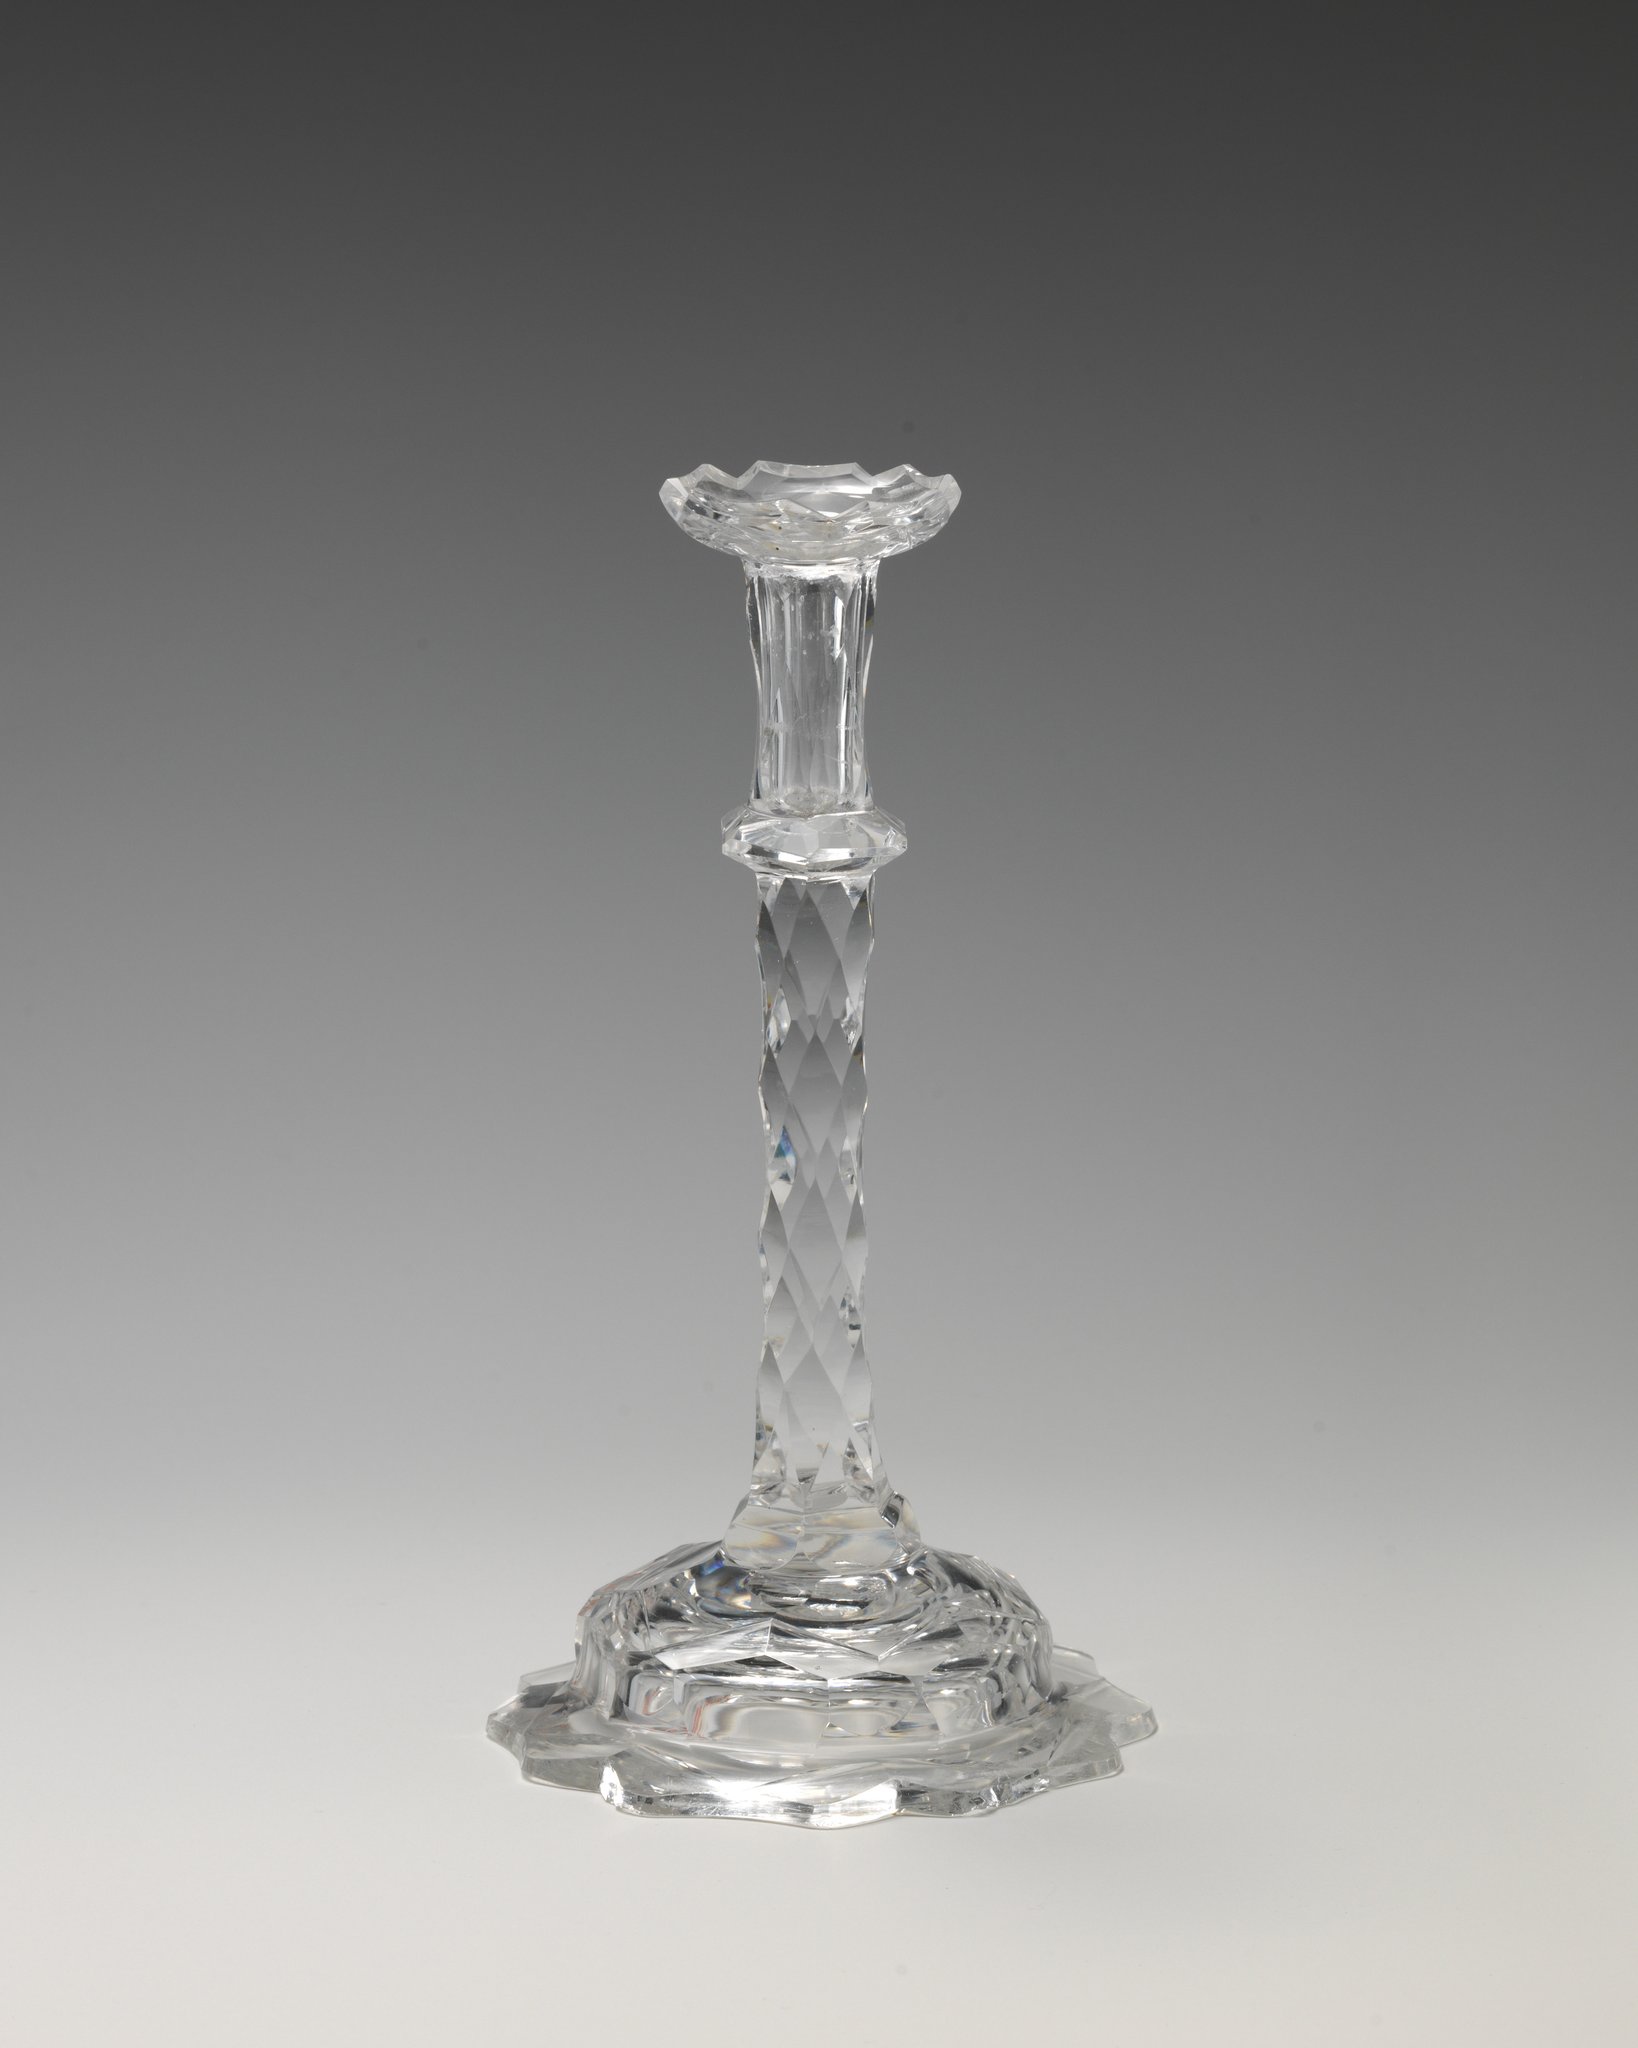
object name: taperstick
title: Taperstick (one of a pair)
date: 1775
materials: glass